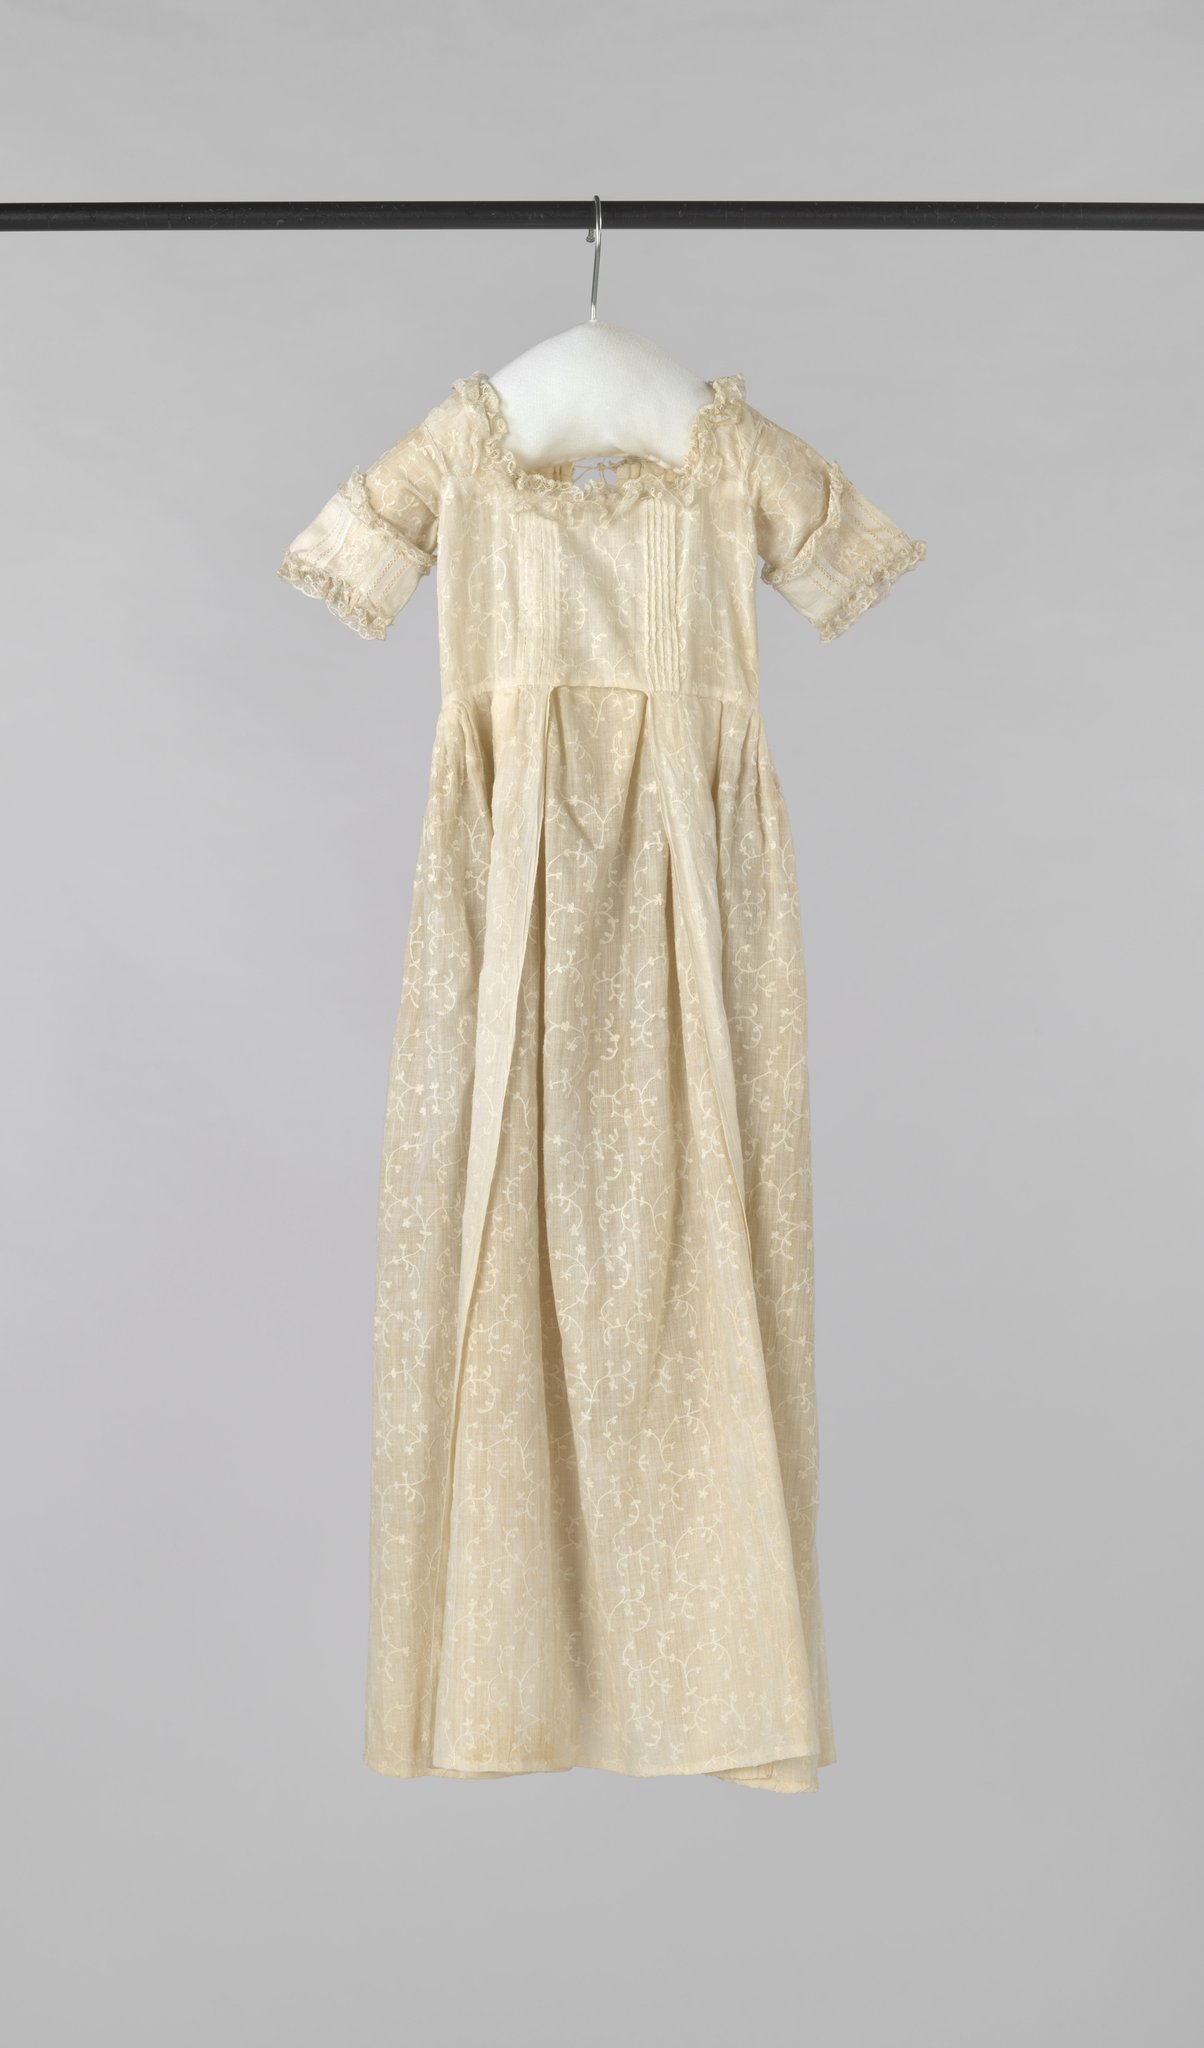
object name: childrenswear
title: Een wit batisten doopjurk, versierd met fijne, in kettingsteek geborduurde rinceaux, gevoerd met witte zijde, de halsopening en mouwen afgezet met fijne linnen kant, en een met kant omzet batisten kraag.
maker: Anonymous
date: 1800-1825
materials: textile, linen, silk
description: Een wit batisten doopjurk, versierd met fijne, in kettingsteek geborduurde rinceaux, gevoerd met witte zijde, de halsopening en mouwen afgezet met fijne linnen kant, en een met kant omzet batisten kraag.